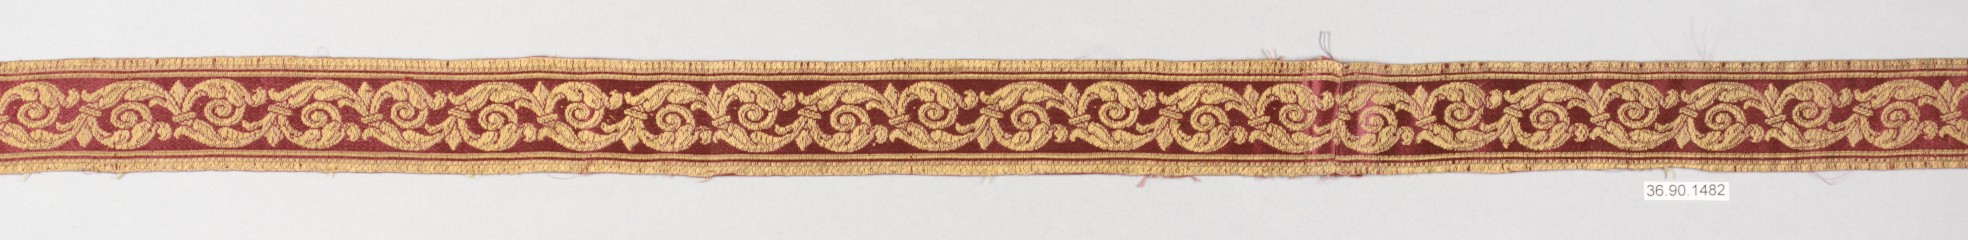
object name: ribbon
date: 1801-1900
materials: silk